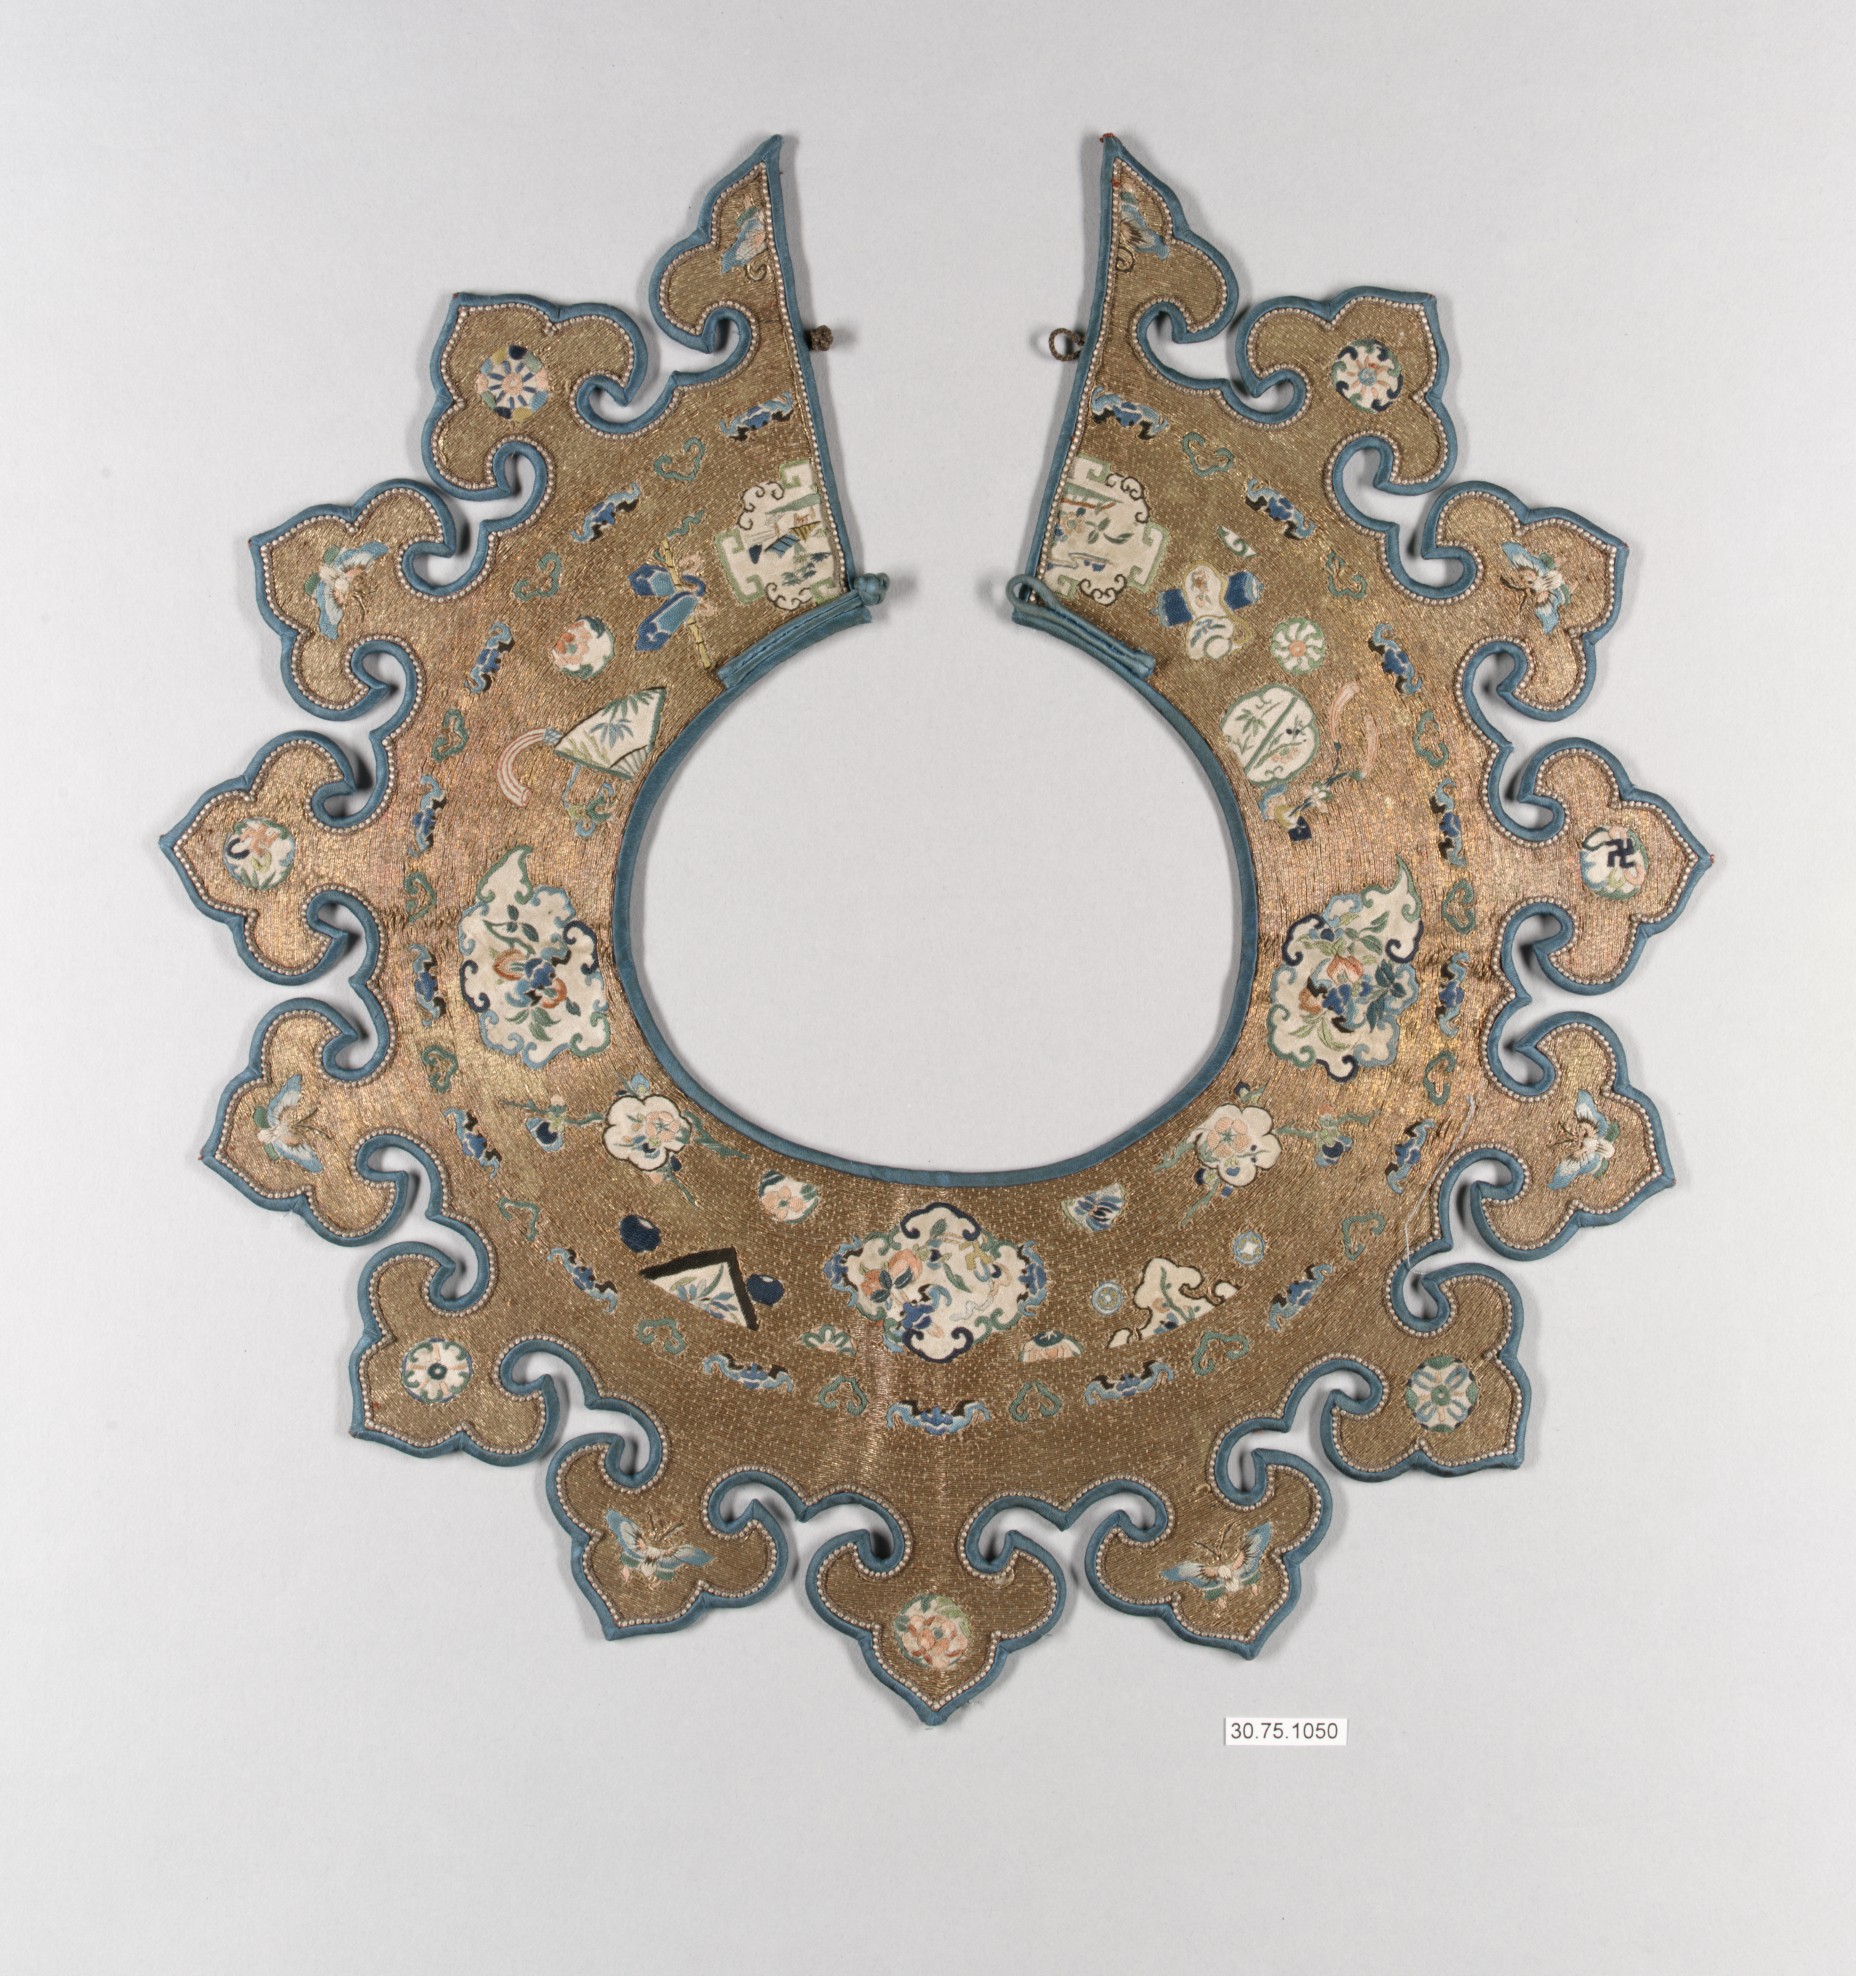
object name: collar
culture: chinese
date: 1644-1911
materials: metal thread, silk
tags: butterflies,flowers